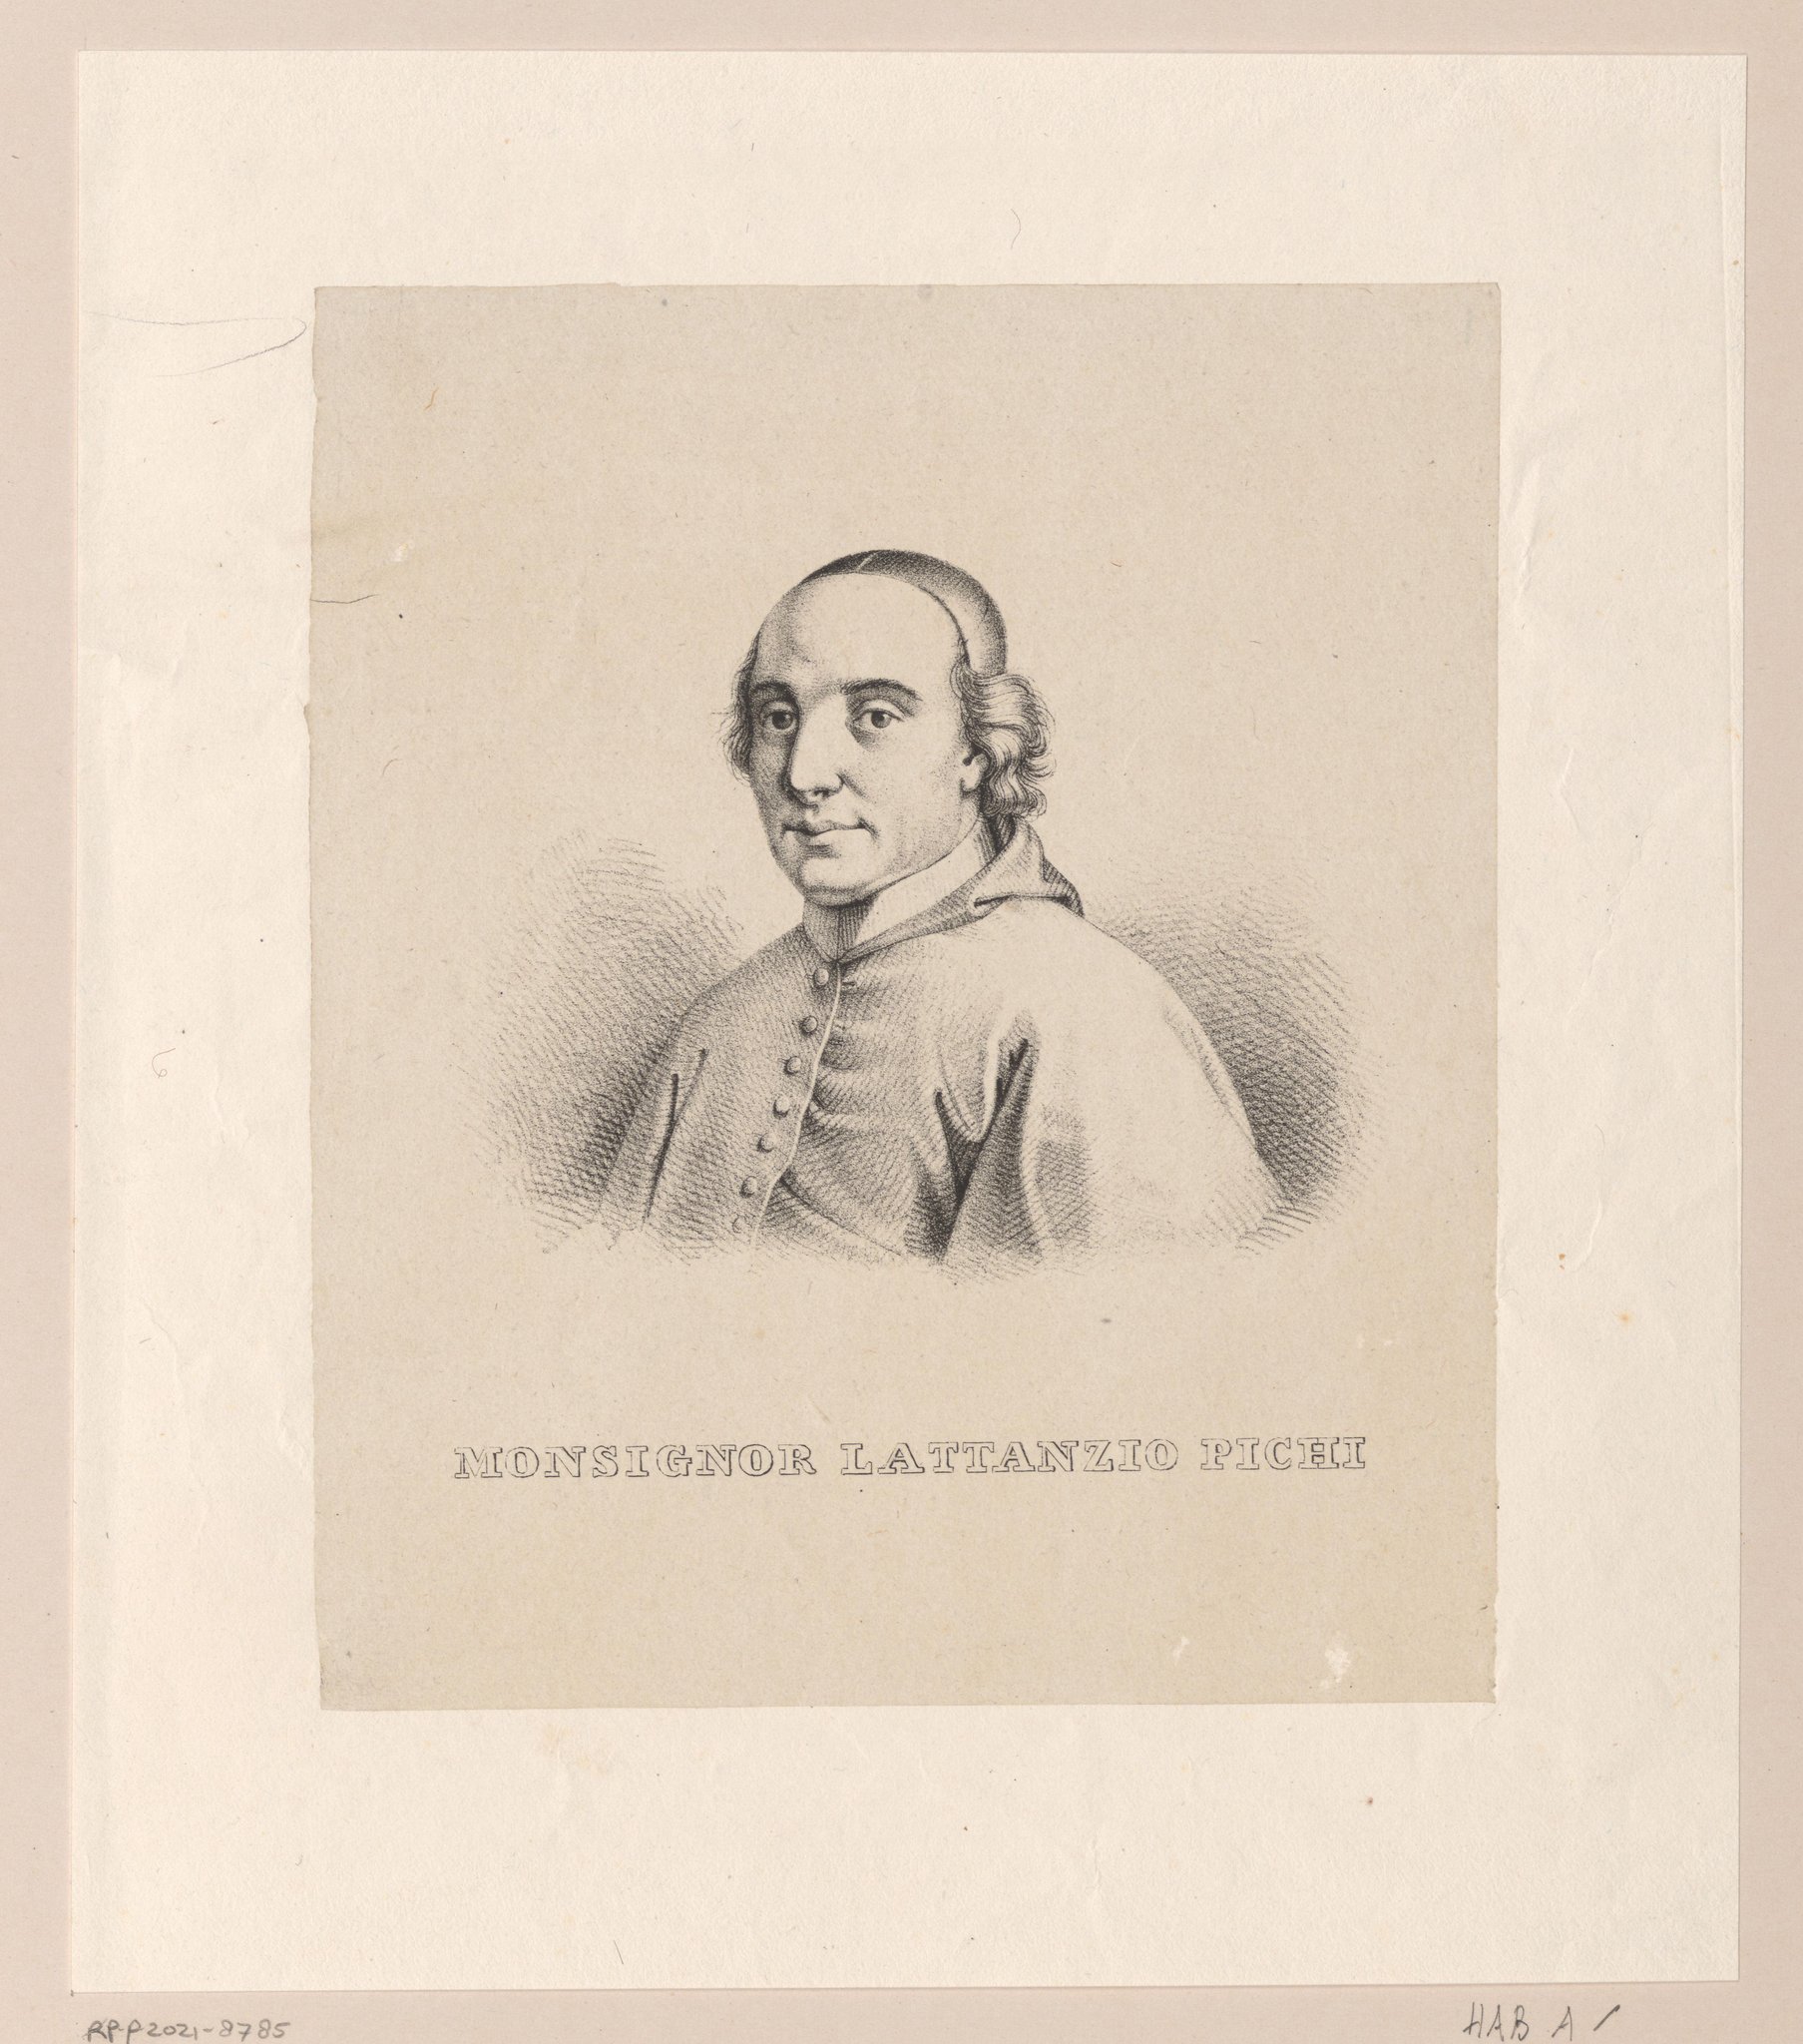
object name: print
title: Portret van Lattanzio Pichi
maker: Anonymous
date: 1820-1899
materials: paper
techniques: lithograph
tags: clergyman, historical persons